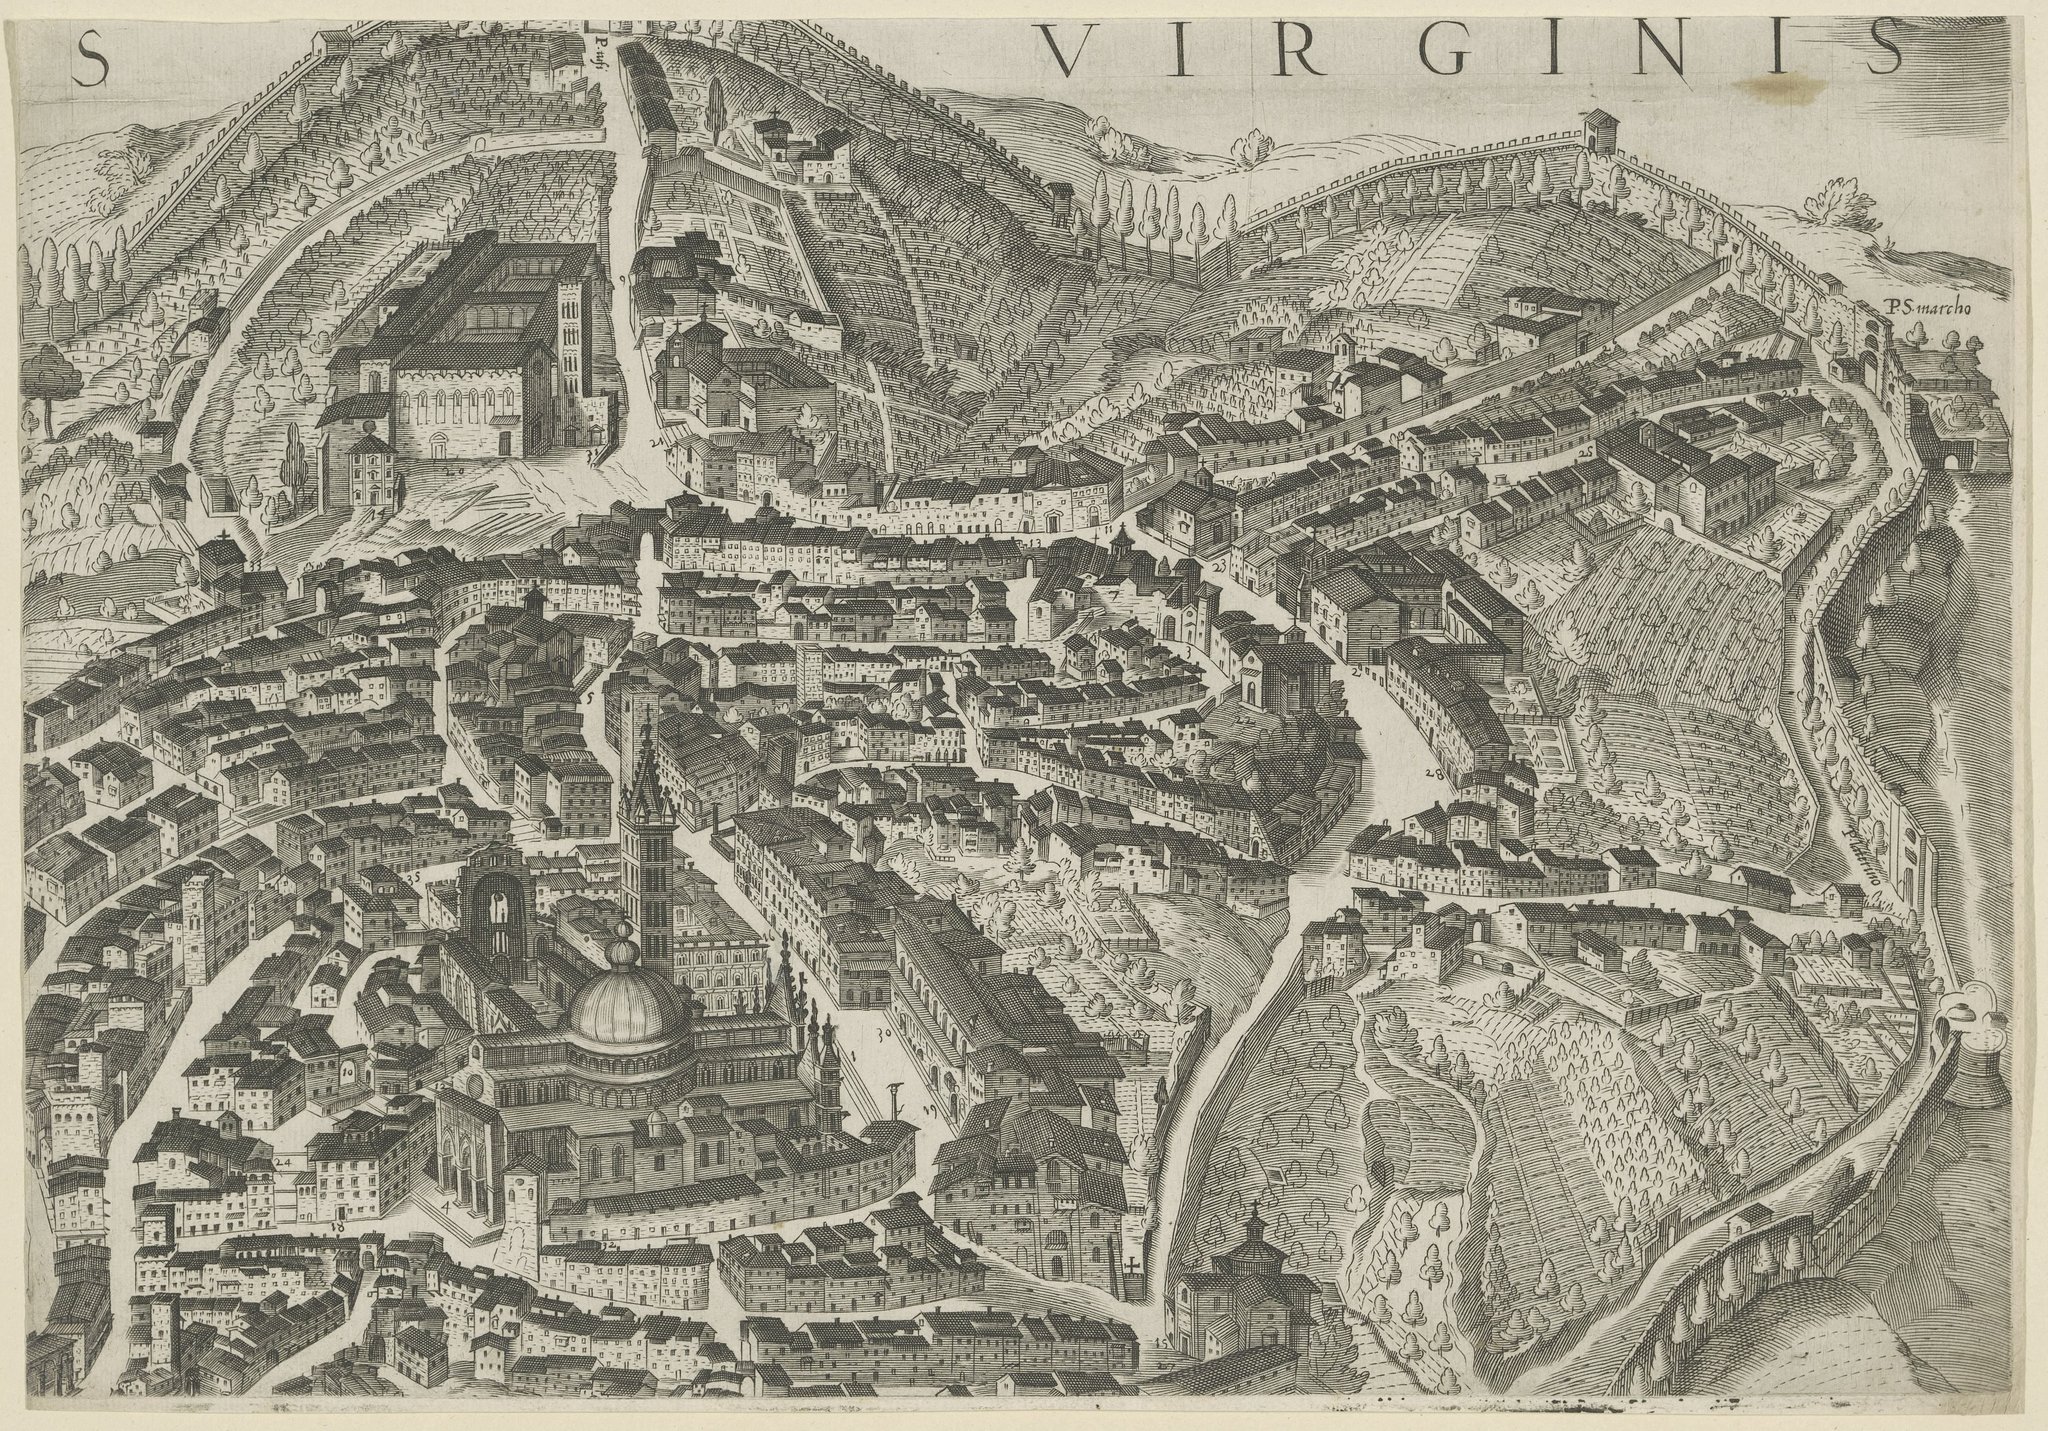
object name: print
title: Senavetus civitas virginis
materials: paper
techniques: engraving, etching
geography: italy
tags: coat of arms (as symbol of the state, etc.), mary (without the christ-child), archbishop, bishop, etc. (roman catholic), city-view in general; 'veduta', maps, atlases, cardinal, saints, female saints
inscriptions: collector's mark: Lugt 240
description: Deel van een plattegrond van Siena. Boven de stad heiligen, bisschoppen, kardinalen en Maria op wolken. Bovenste helft van prent is afgesneden.